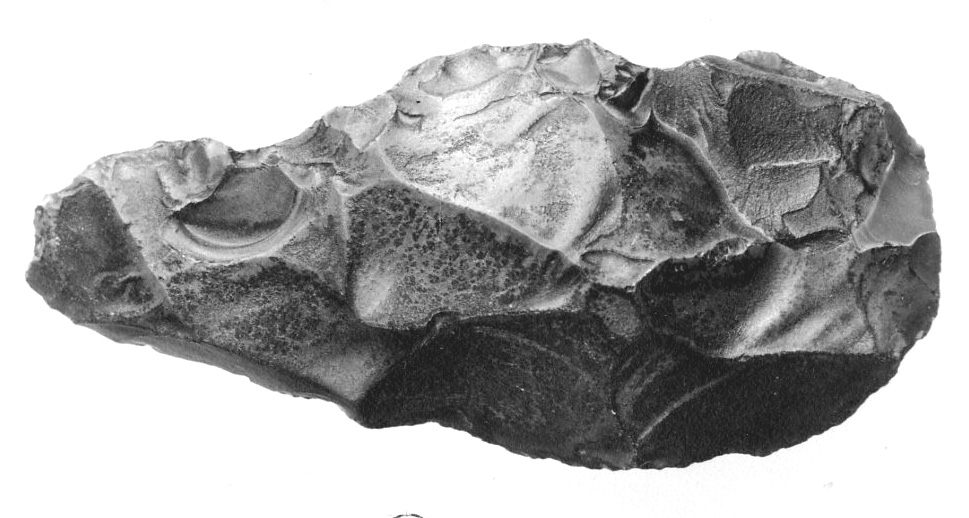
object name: tool, biface, hand ax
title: Biface, commonly referred to as a hand ax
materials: stone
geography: egypt